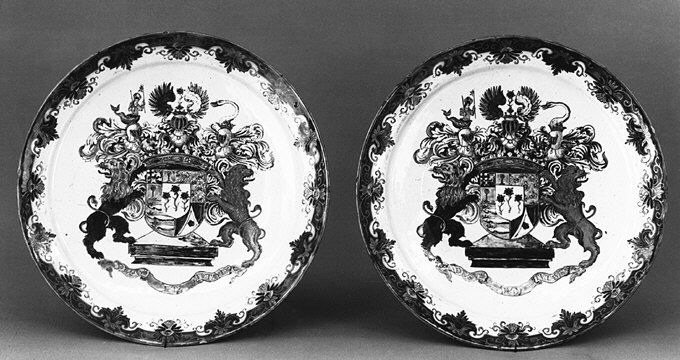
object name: plate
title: Pair of plates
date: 1734-1766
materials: earthenware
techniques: glazing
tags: coat of arms